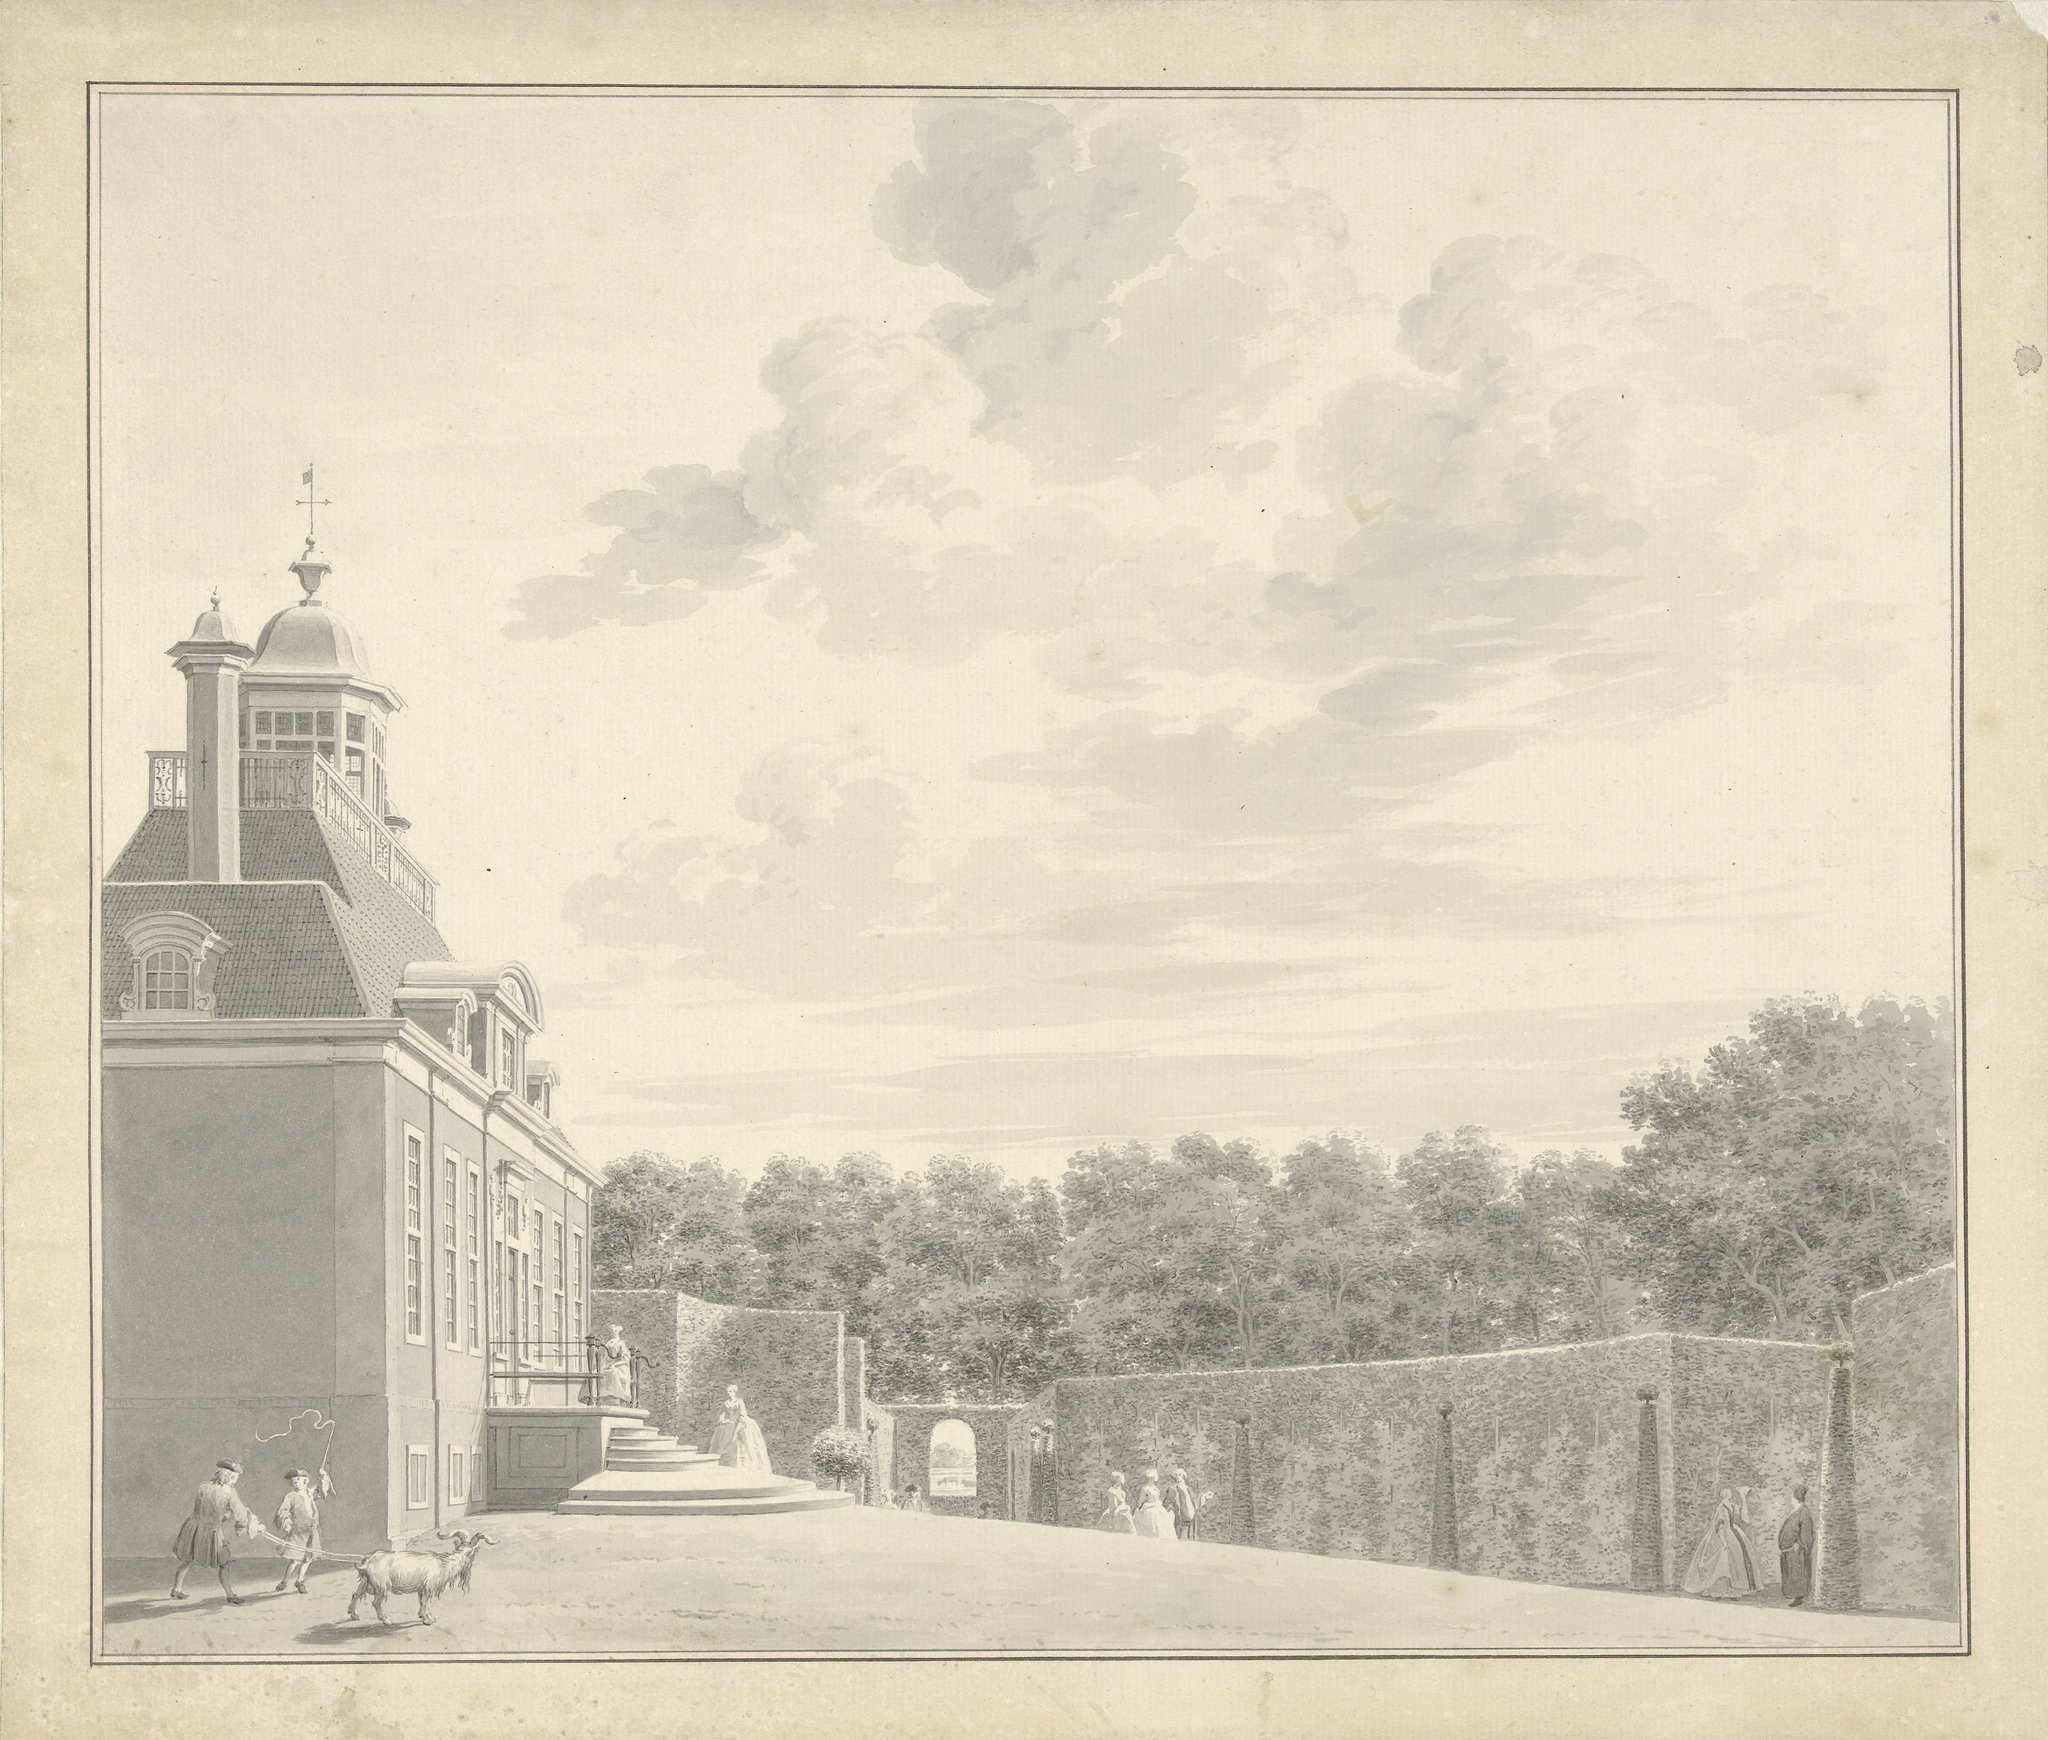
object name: drawing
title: Views of the Estate Spieringshoek between Schiedam and Vlaardingen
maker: cornelis pronk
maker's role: draughtsman, painter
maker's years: 1691-1759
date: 1750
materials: paper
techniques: brush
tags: rural housing, e.g. country-house, villa, cottage, villa, country-house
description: Cornelis Pronk became well known for his topographical drawings and porcelain designs, after having moved away from painting portraits. He travelled widely throughout the Netherlands to draw cities, towns, and landscapes, sometimes focusing on specific buildings. The resulting output is characterized by airy and picturesque compositions. These four drawings feature the Spieringshoek estate just outside Rotterdam.